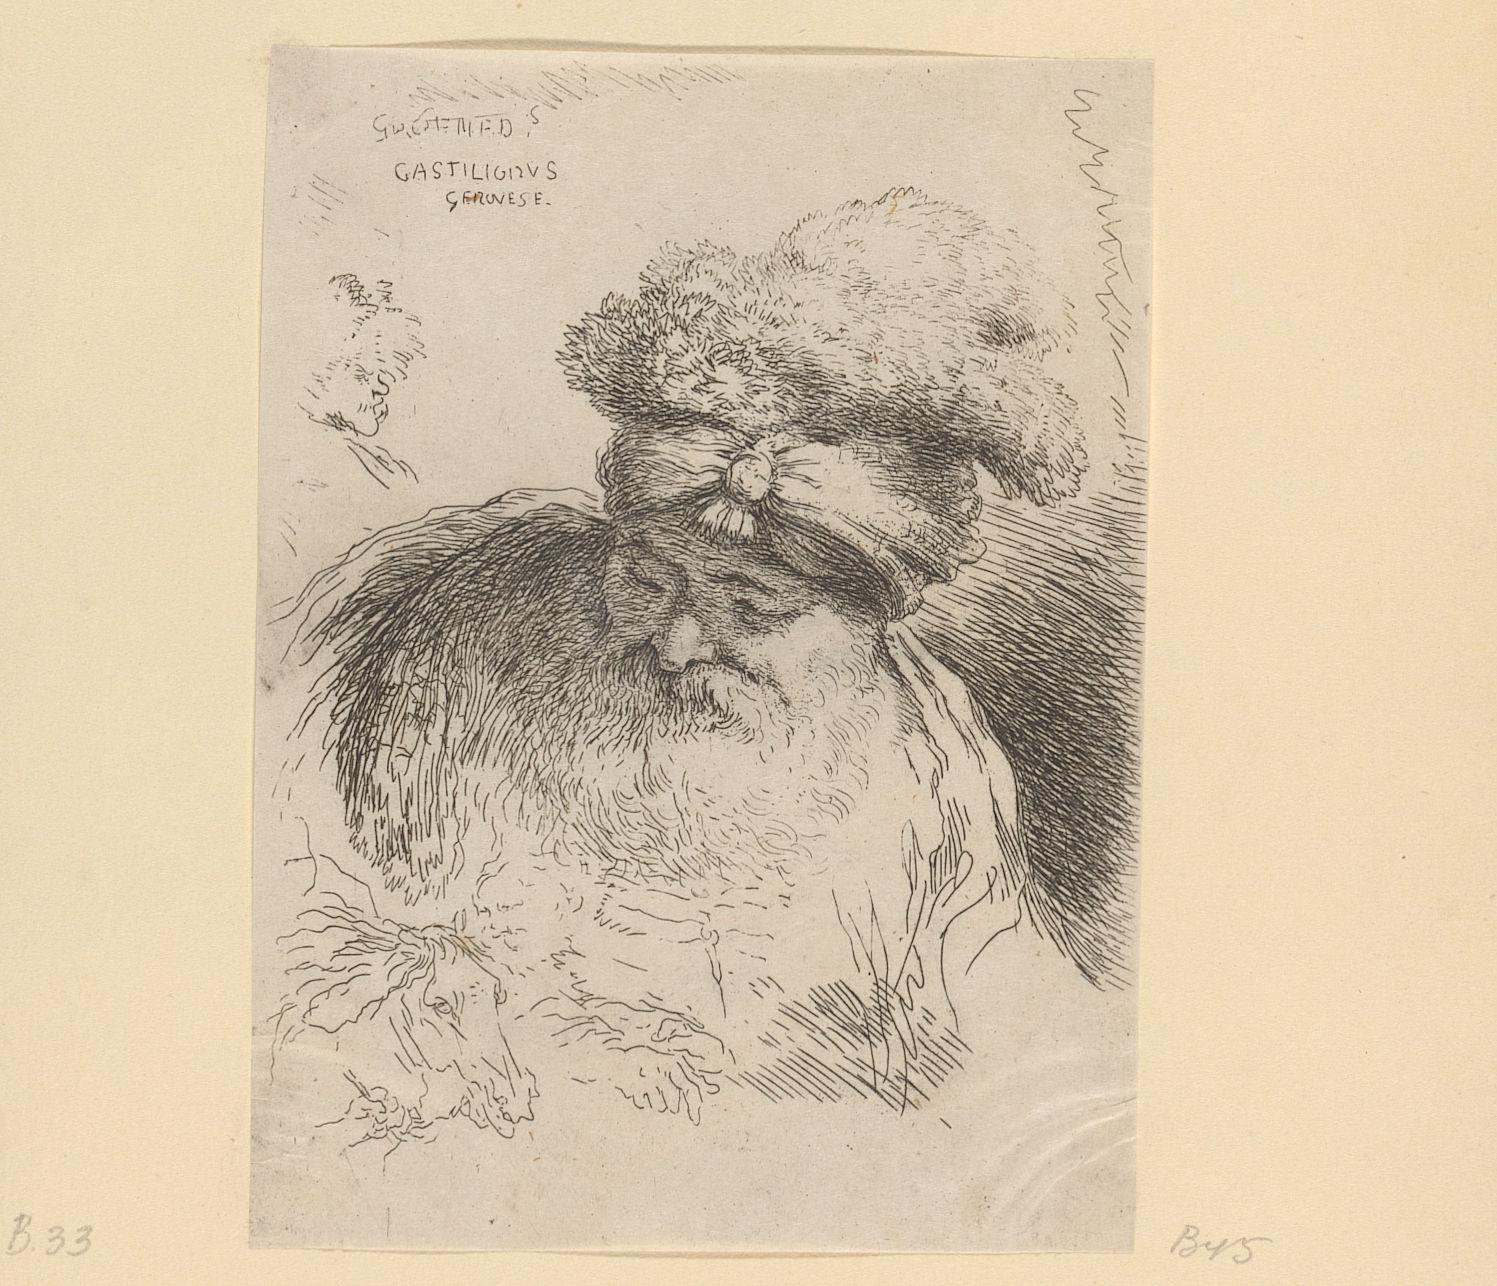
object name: print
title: Kleine studie van hoofden met oosterse hoofddeksels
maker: giovanni benedetto castiglione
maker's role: draughtsman, print maker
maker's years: 1610-1665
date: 1645-1650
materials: paper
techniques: etching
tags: head (human), head-gear: cap (+ men's clothes), head-gear: cap (+ fur used for clothes)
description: Prent is onderdeel van een serie van zestien prenten. Prent maakt mogelijk deel uit van een serie van 200 prenten. Deze serie is onder de titel 'A Collection of two hundred original etchings' voor het eerst uitgegeven door J.M. Greery in 1816.